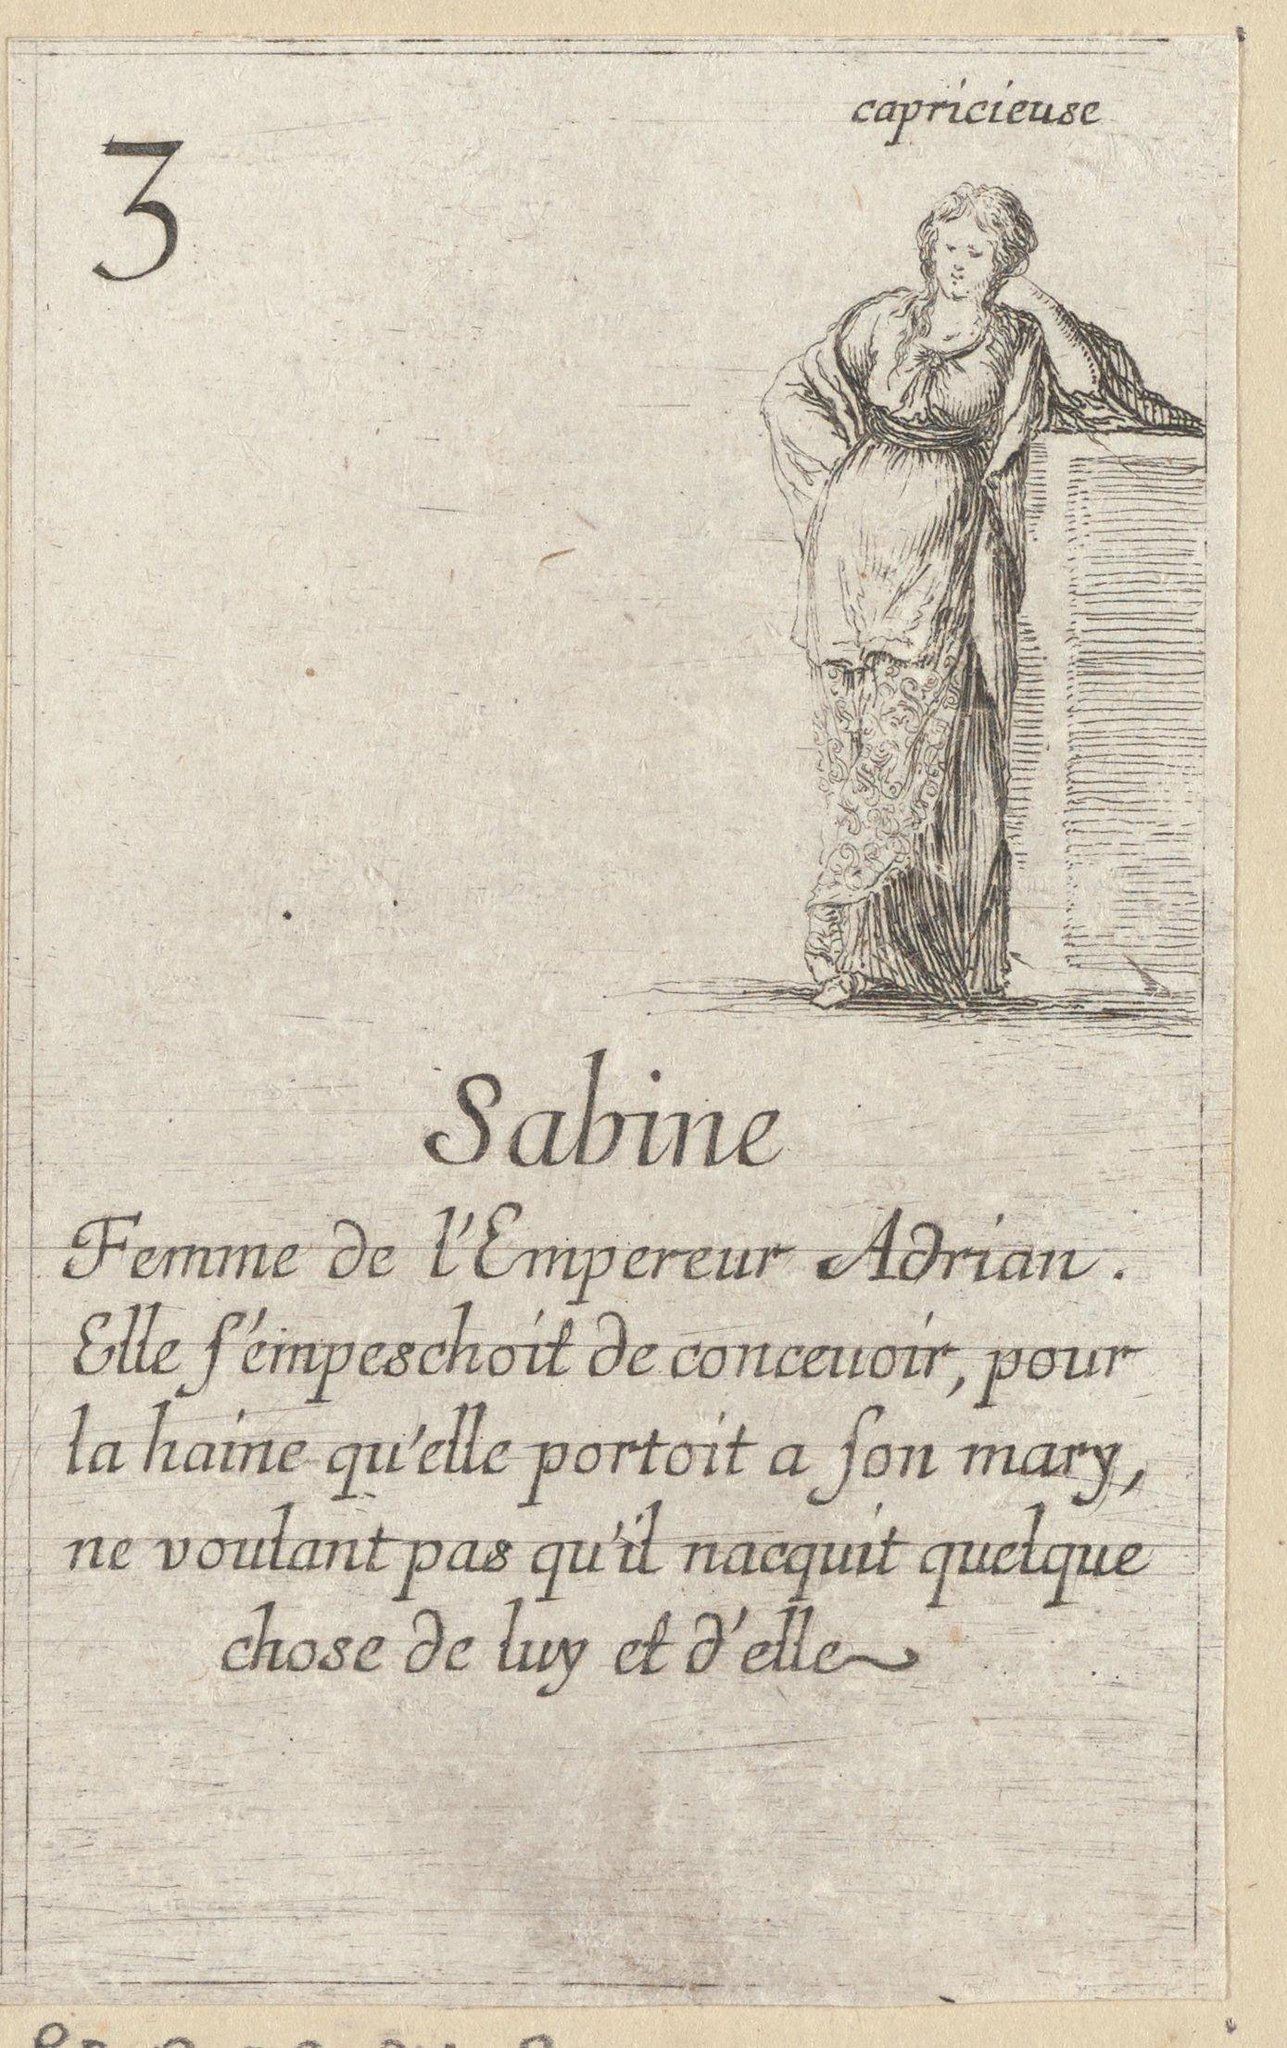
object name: print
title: Kaartspel met gerenommeerde heerseressen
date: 1620-1664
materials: paper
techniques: etching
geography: paris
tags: ruler, sovereign - bb - female ruler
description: Deze prent maakt deel uit van een kaartspel met 52 kaarten met voorstellingen van beroemde koninginnen. De serie is uitgedacht door Jean Desmarests de Saint-Sorlin in opdracht van Kardinaal Mazarin. Het kaartspel werd gemaakt voor de jonge Lodewijk XIV, samen met het Jeu des Fables, Jeu de la Géographie en Jeu des Rois de France.